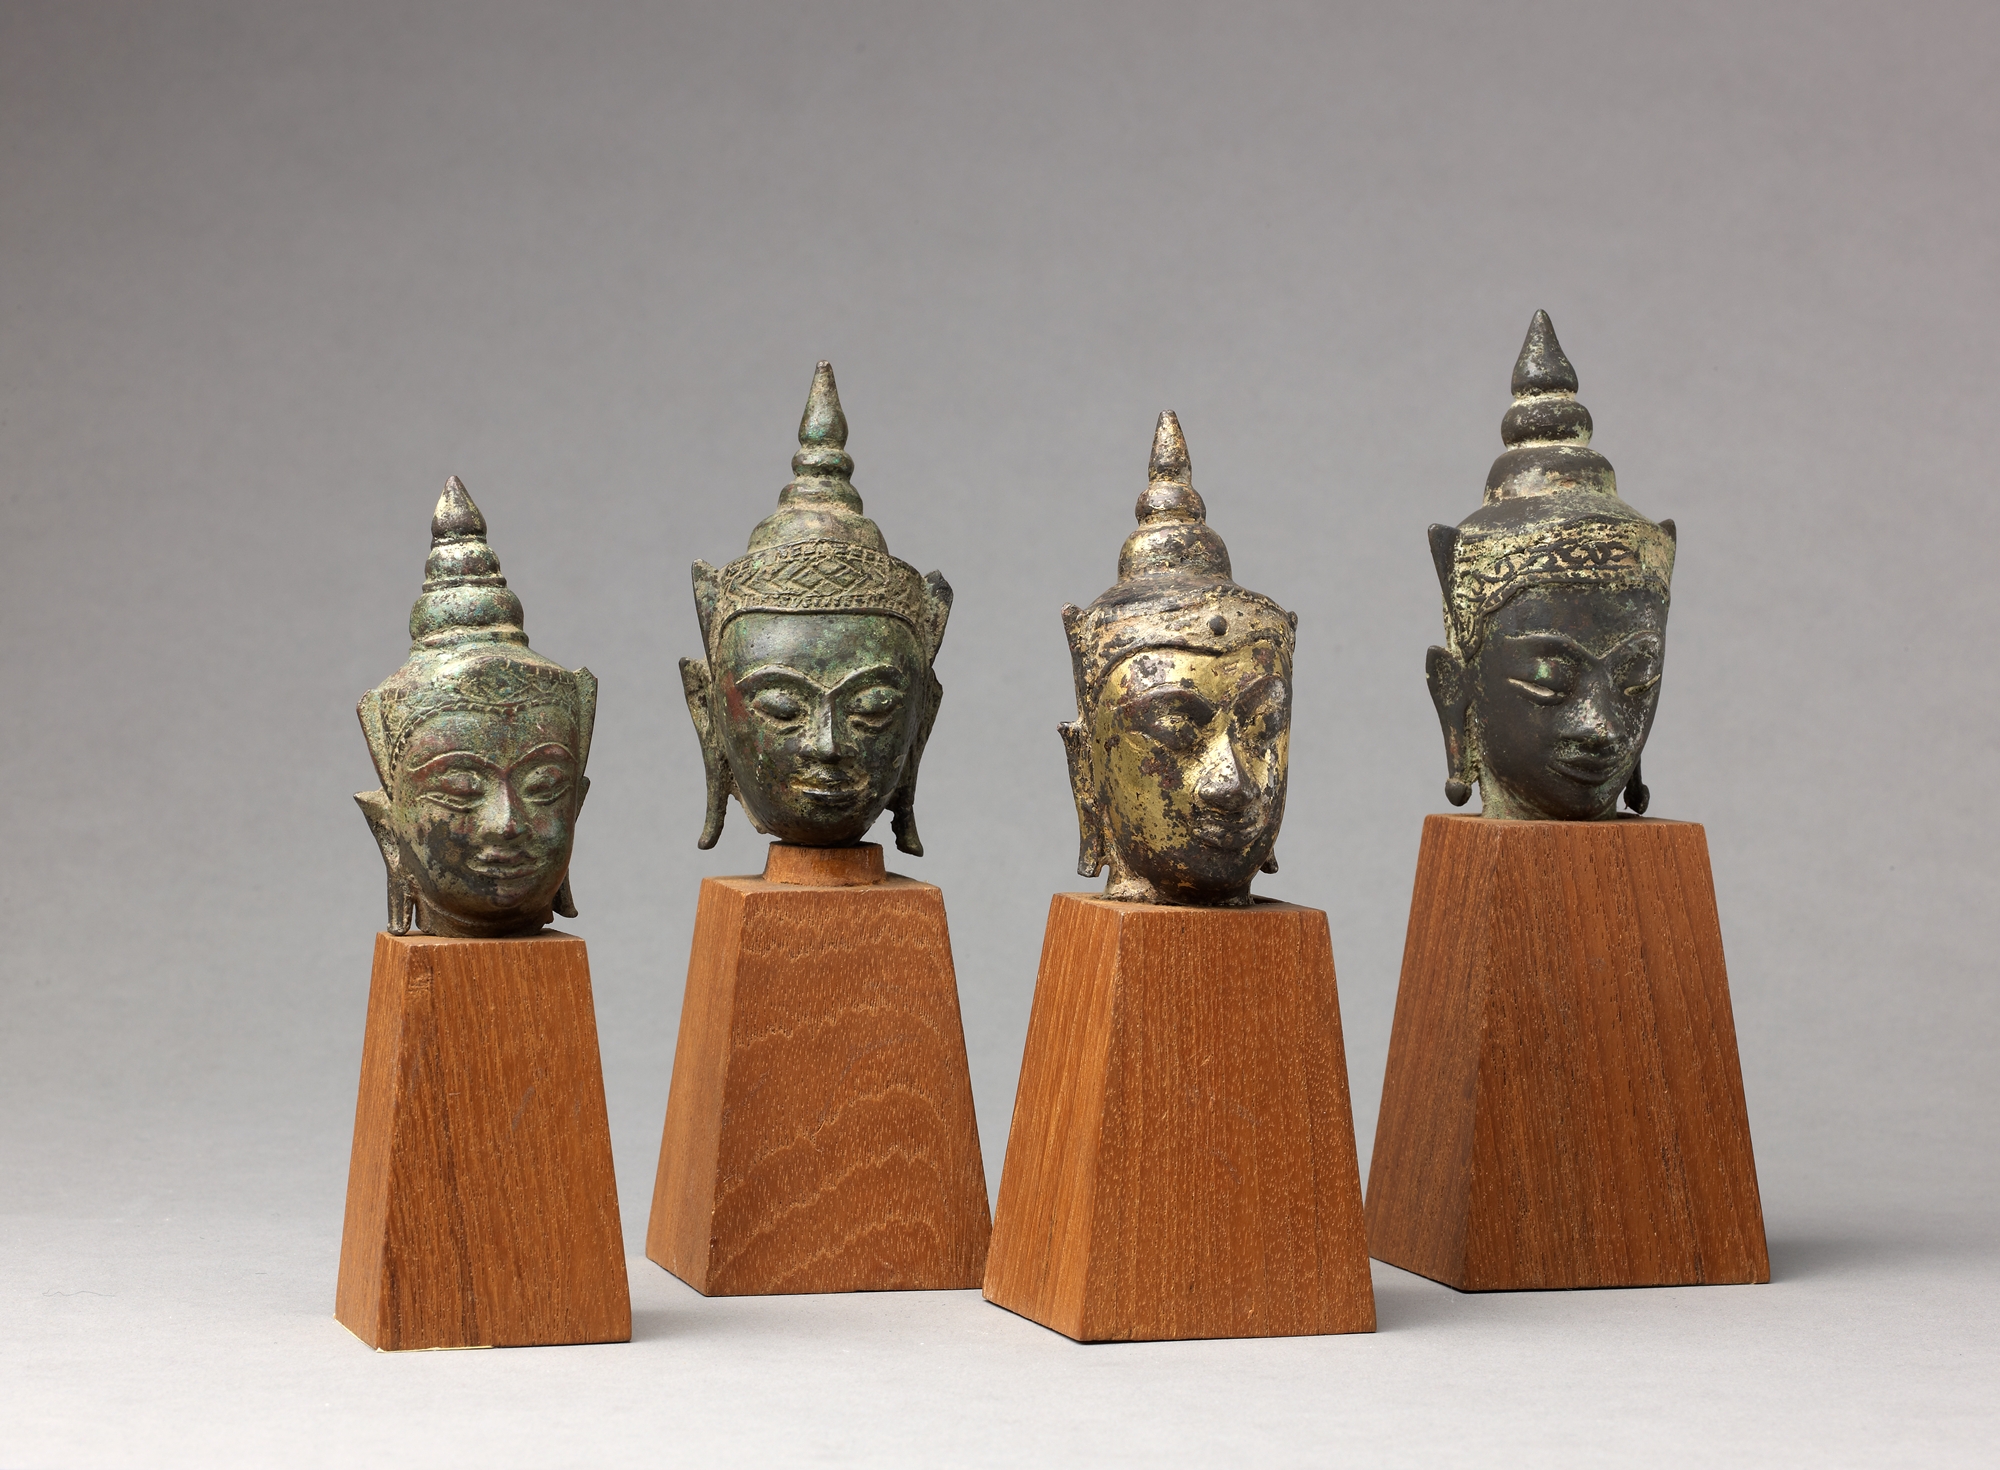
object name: sculpture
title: Head of the Buddha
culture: thai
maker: thai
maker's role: artist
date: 1767-1900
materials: copper alloy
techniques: gilding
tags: heads,buddha